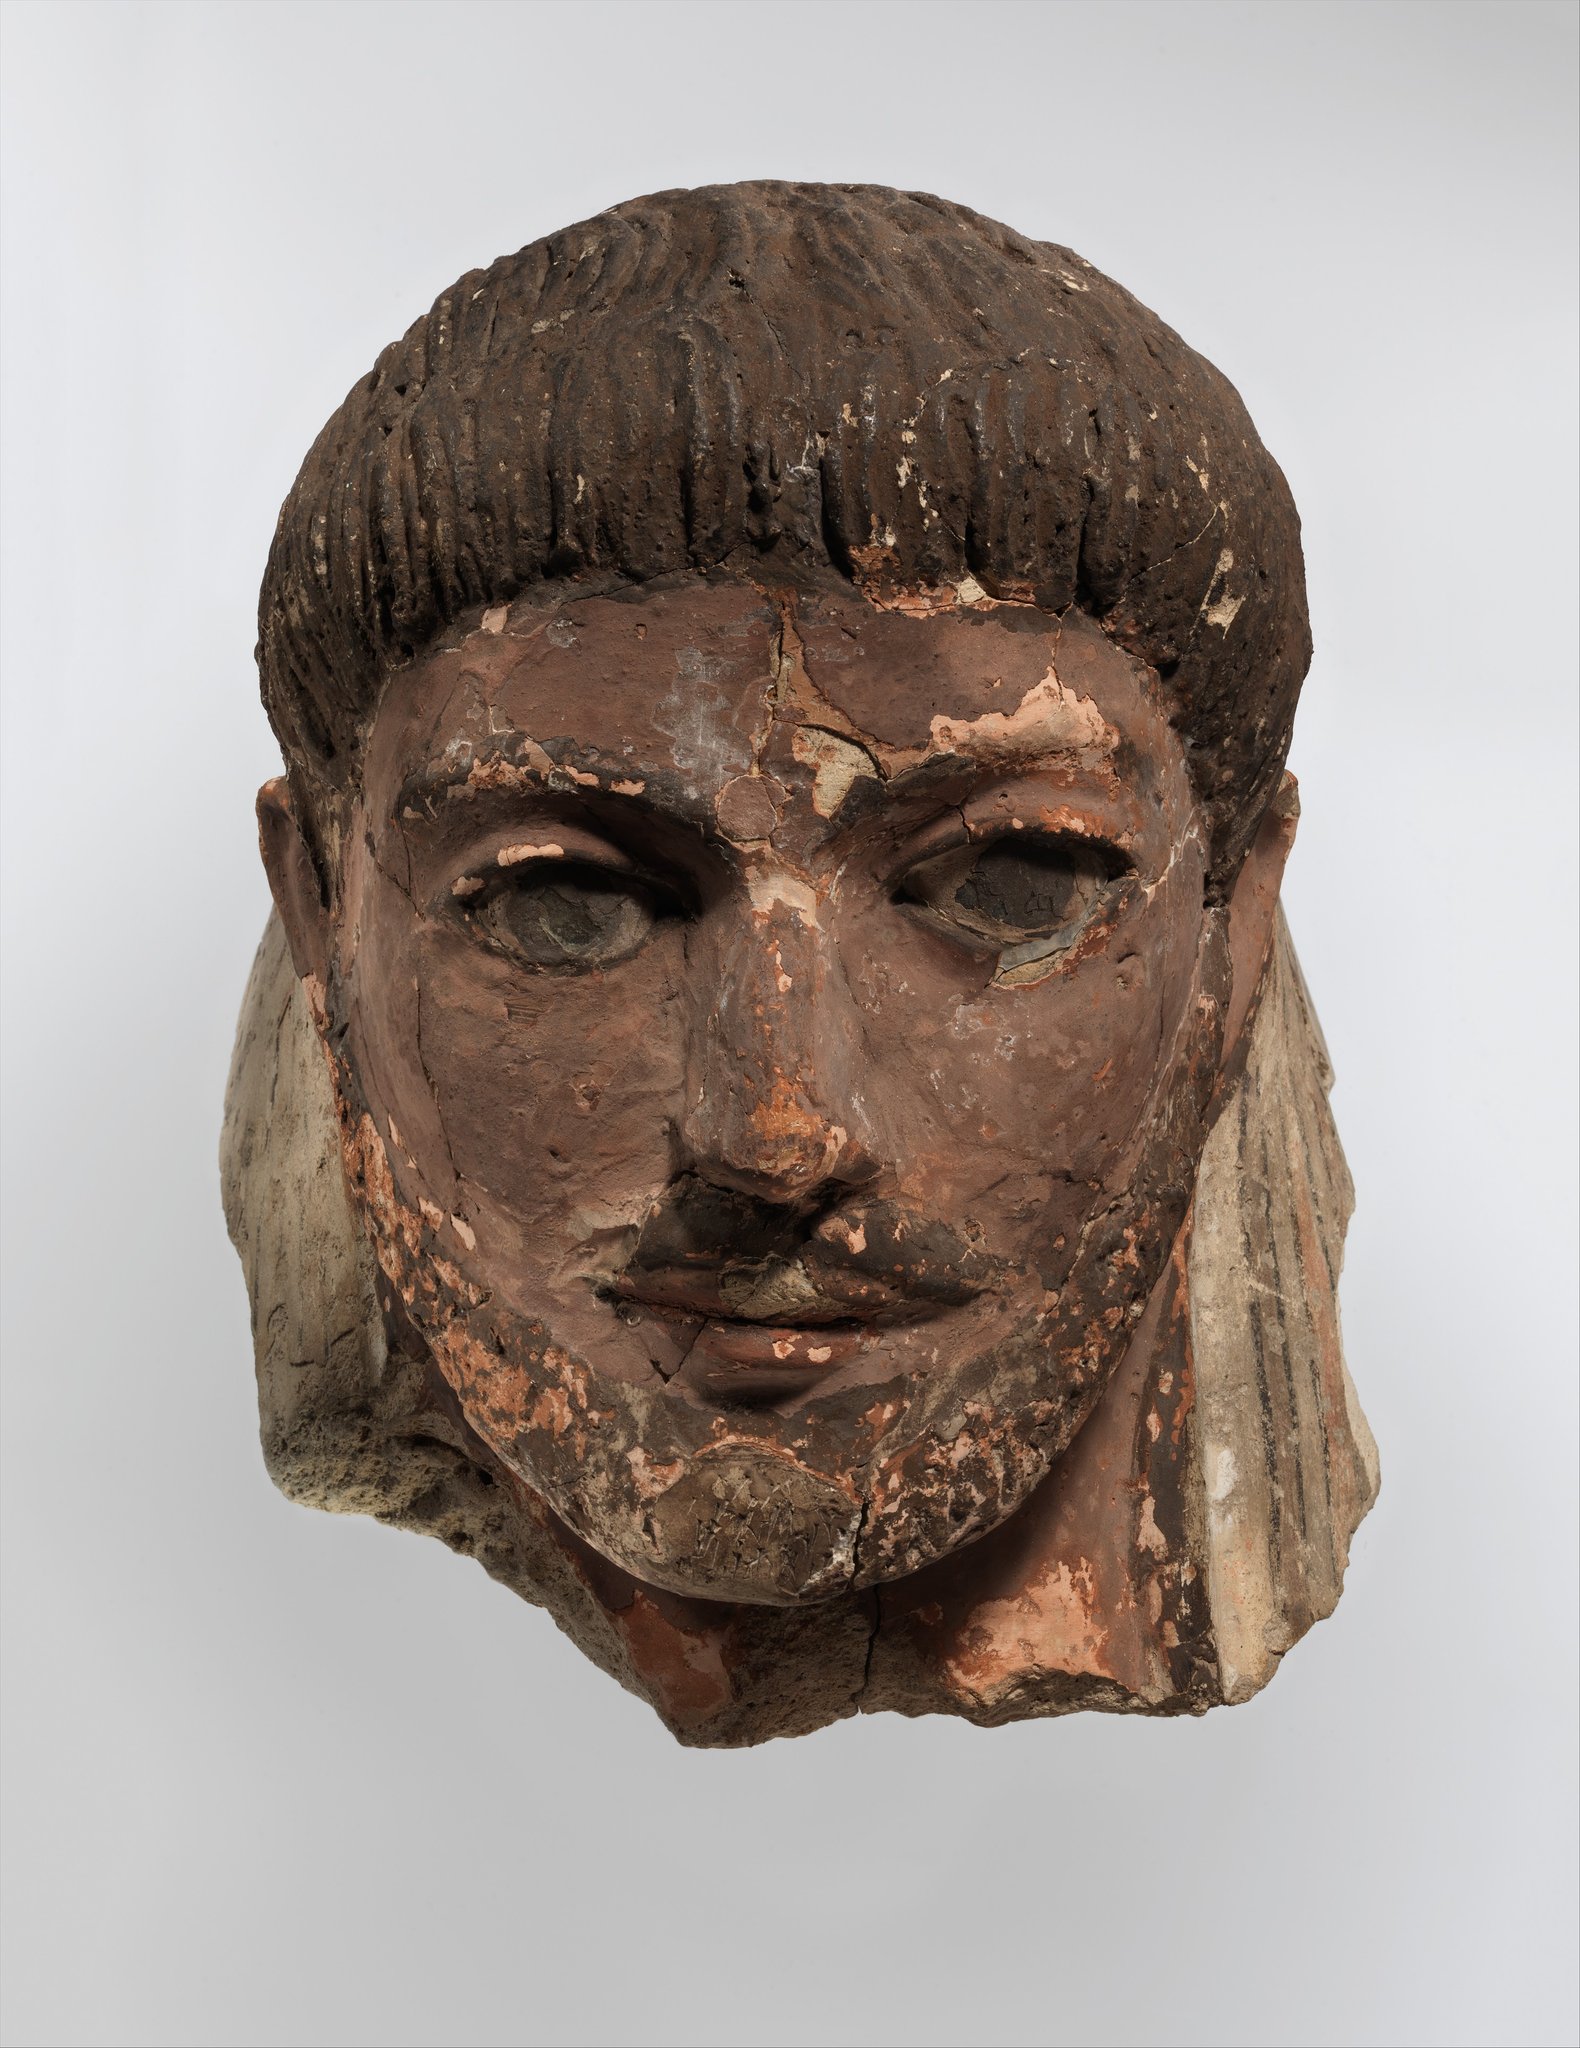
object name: mask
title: Funerary Mask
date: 125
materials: paint, plaster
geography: egypt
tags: heads,men